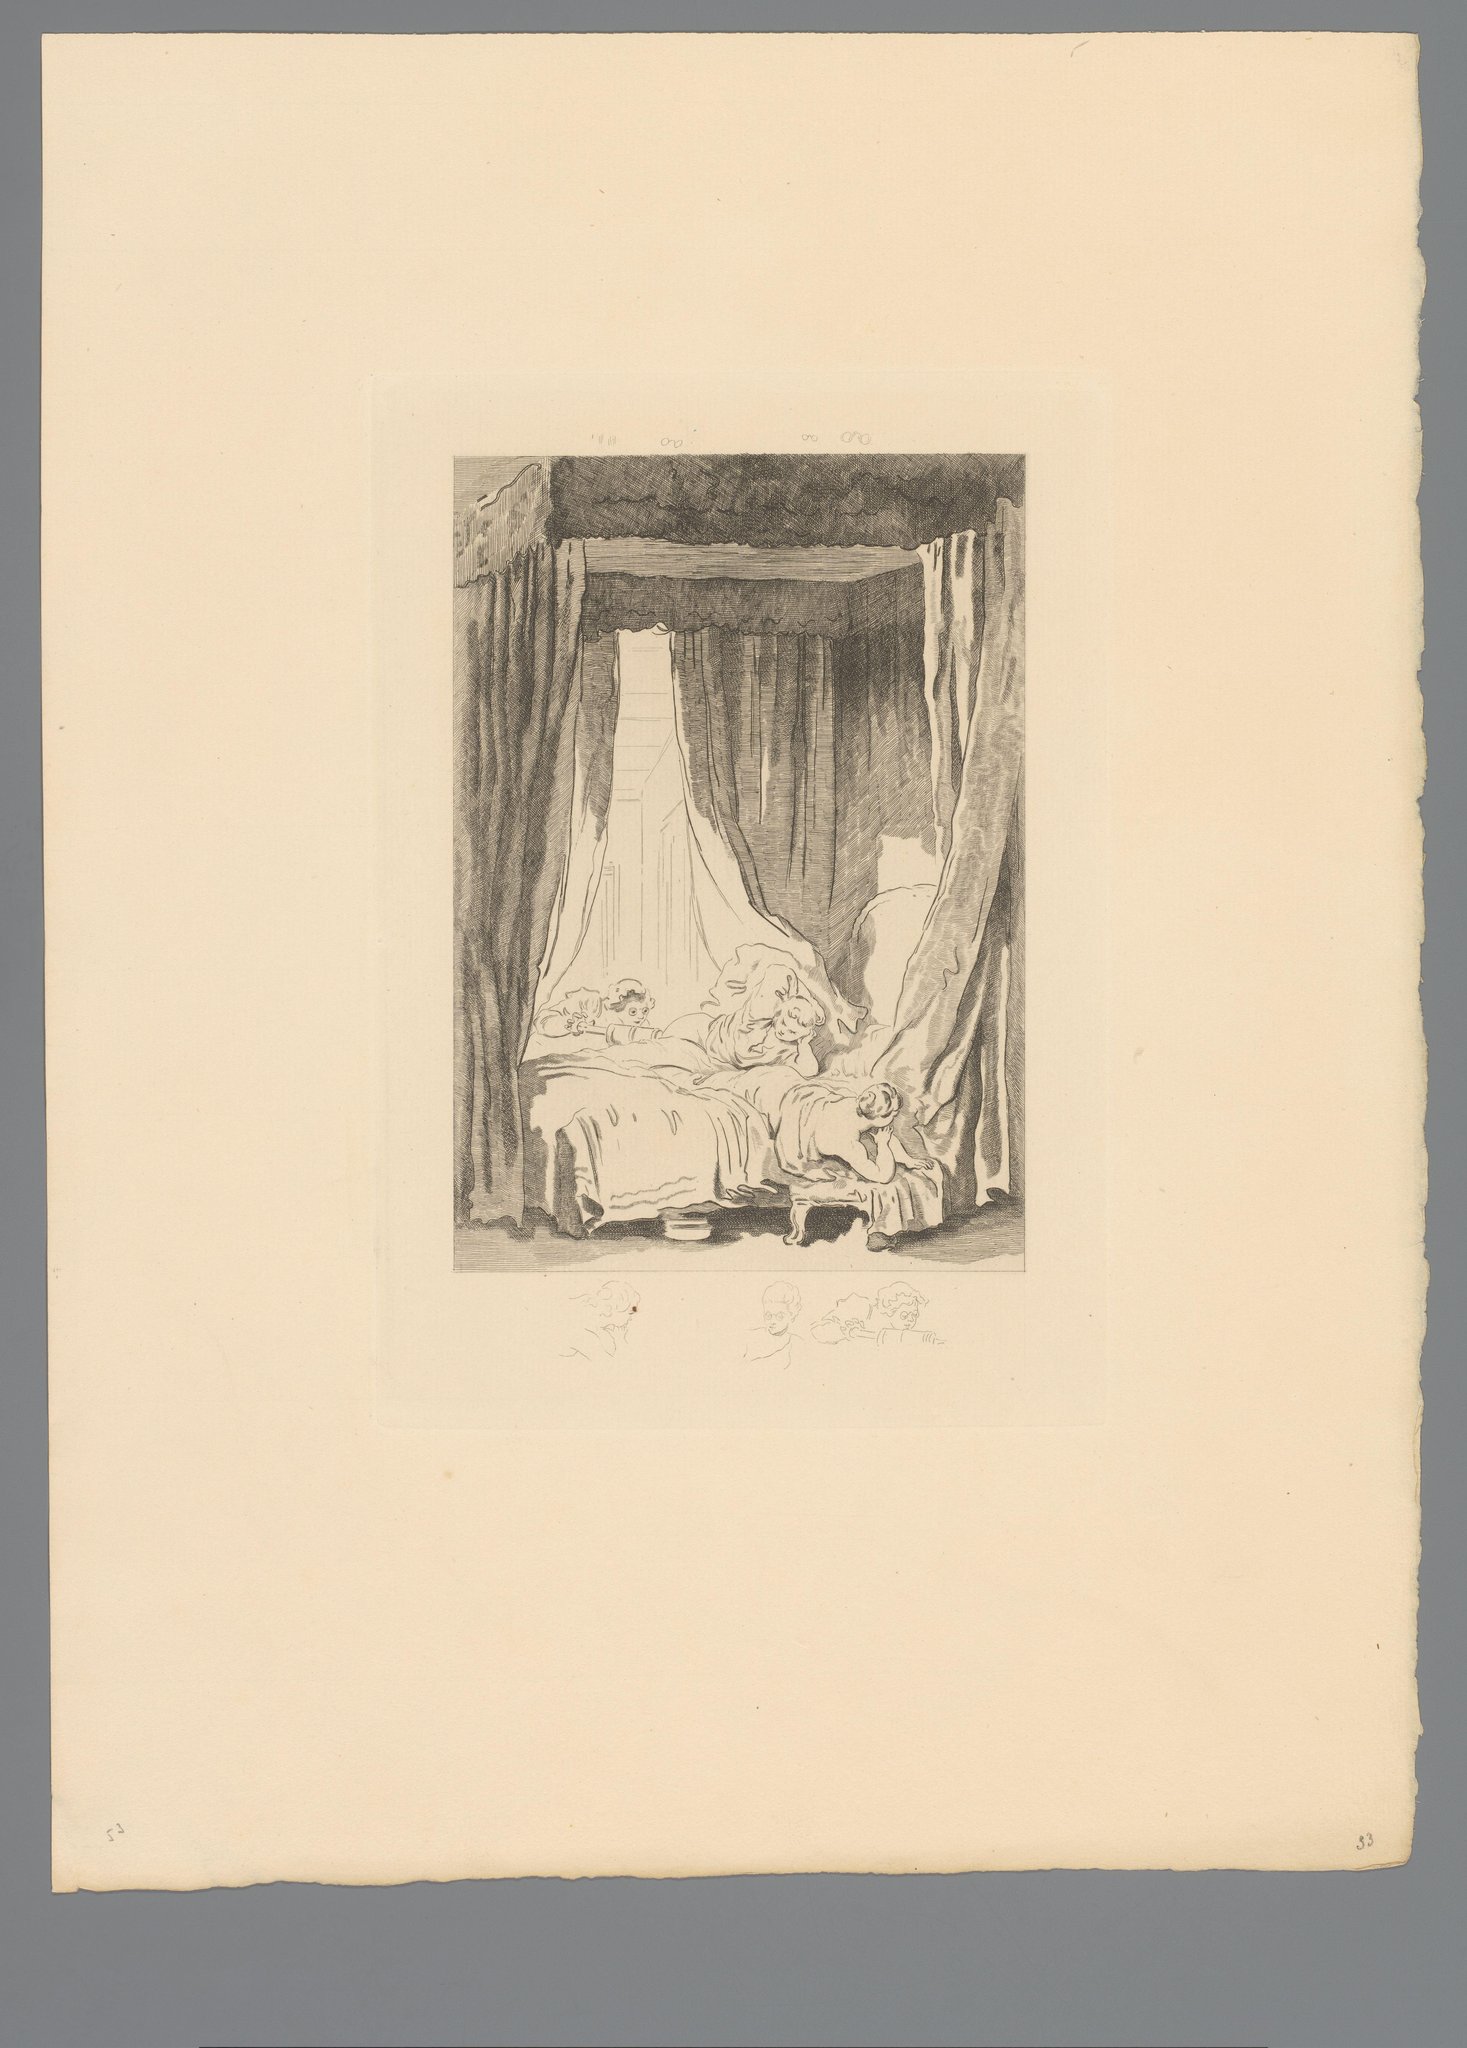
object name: photomechanical print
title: Reproductie van een prent naar een tekening van een vrouw die een man een spuit geeft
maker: Anonymous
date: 1880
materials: paper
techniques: photoaquatint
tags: enema, squirt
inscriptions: collector's mark:, collector's mark: Lugt 2228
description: Martial Potémont maakte etsen naar de tekeningen van Fragonard, die zich bevonden in een manuscript in de collectie van de verzamelaar Eugène Paillet. Rouquette bood hem aan de tekeningen zo exact mogelijk in prent te laten brengen door Martial Potémont: dit resulteerde in een serie van 57 etsen. Vervolgens werden deze gereproduceerd door middel van heliogravure. Deze omslag betreft een editie voor de letter, "Eau forte pure", de 1e staat van 3 waar men uit kon kiezen bij deze serie.